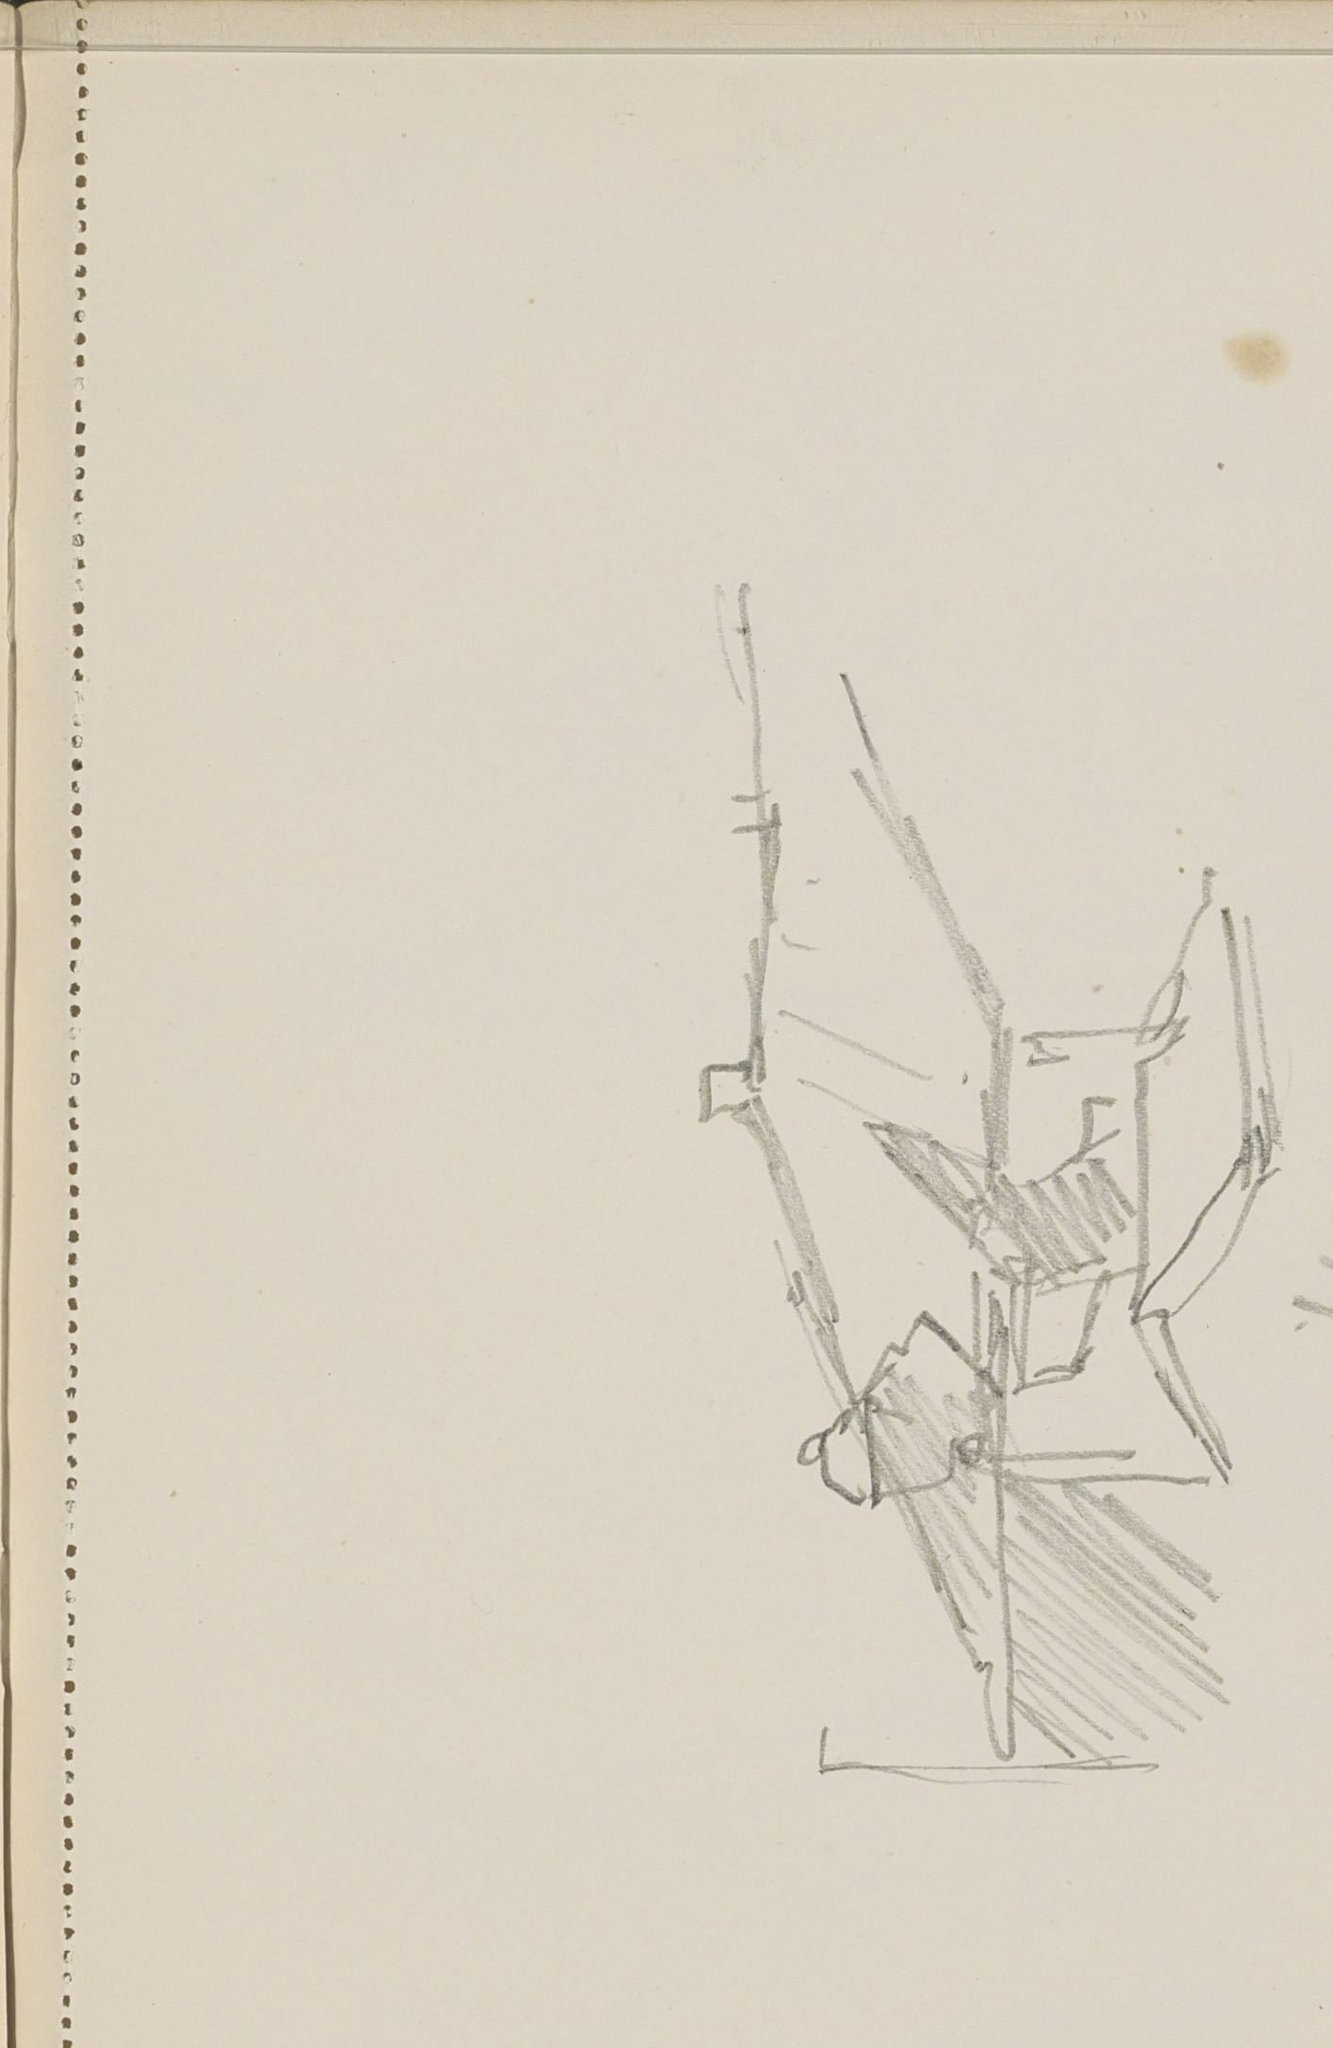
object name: sketchbook leaf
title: Daken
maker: cornelis vreedenburgh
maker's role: draughtsman, print maker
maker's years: 1880-1946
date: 1890-1946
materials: paper, pencil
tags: roof (of house or building)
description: Blad 27 recto uit een schetsboek met 59 bladen.